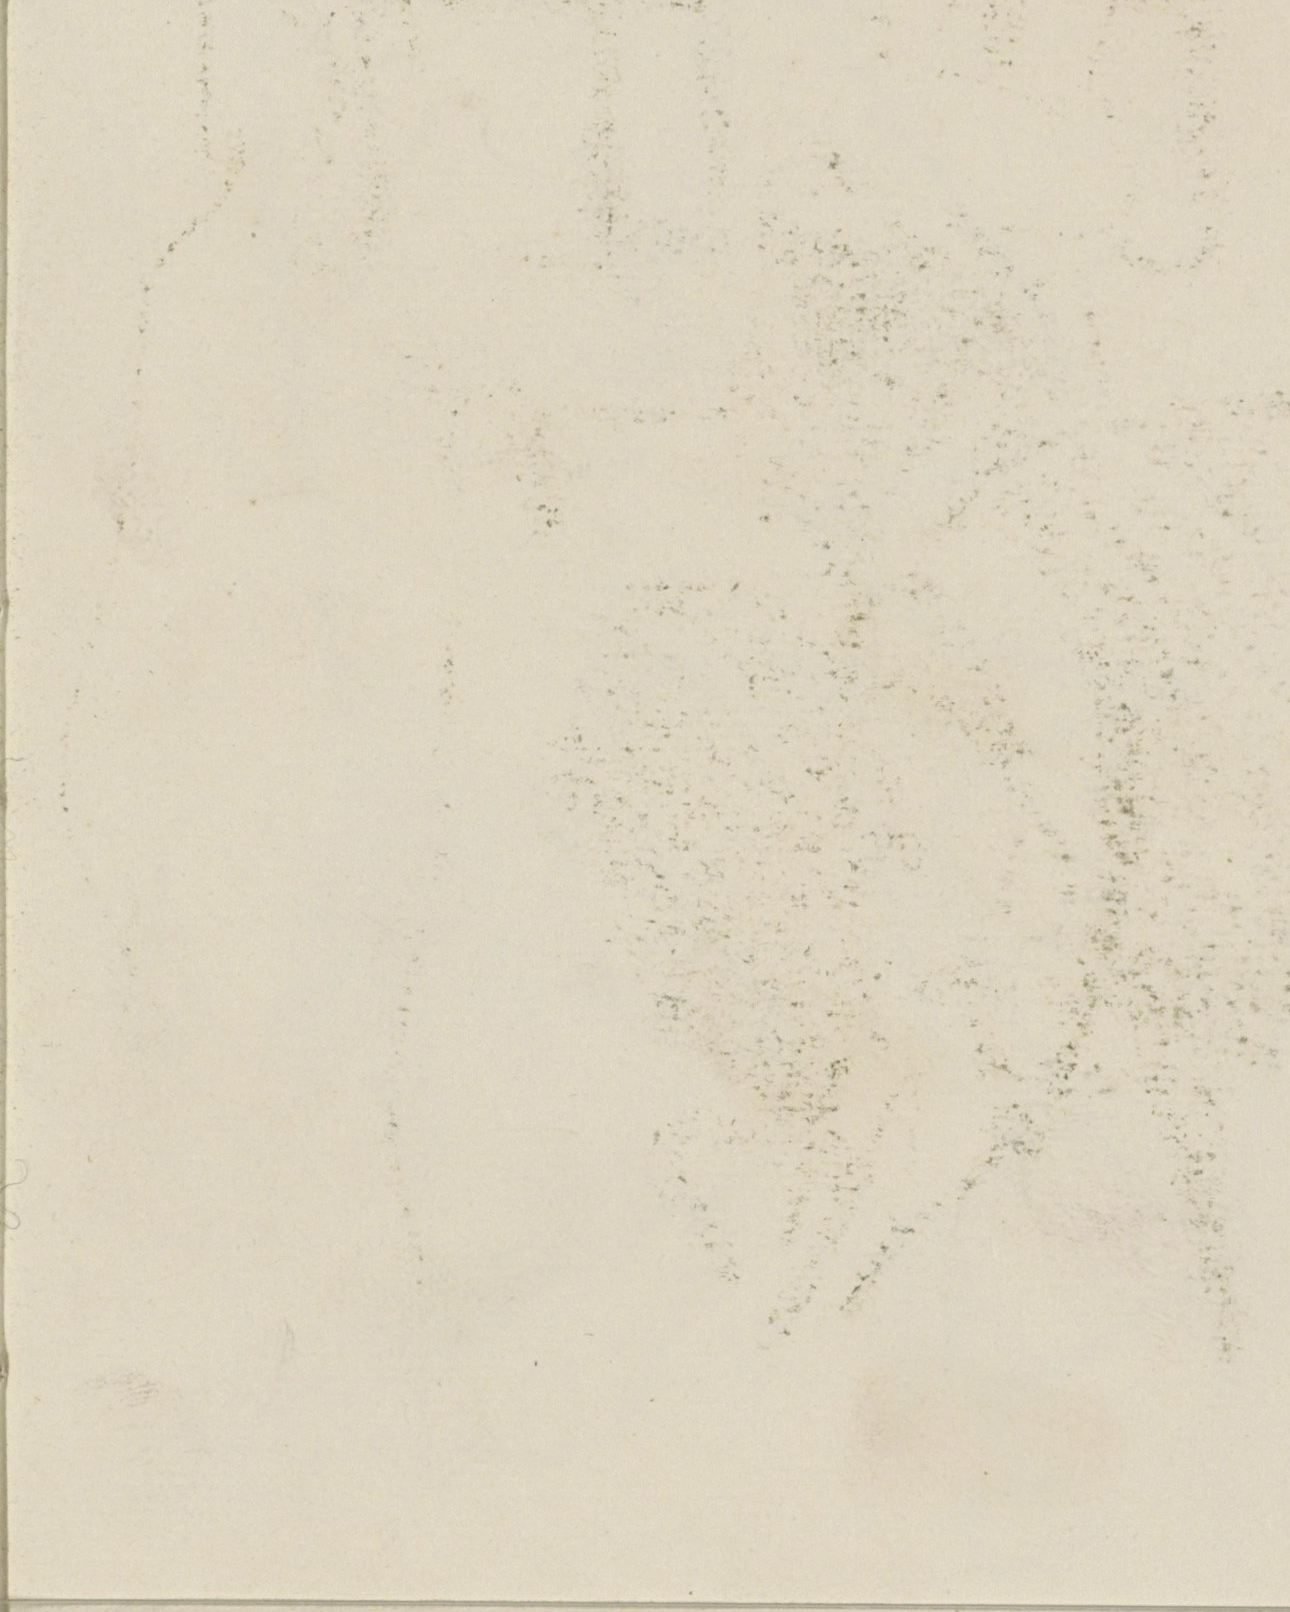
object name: sketchbook leaf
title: Abklatsch van de krijttekening op pagina 58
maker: isaac israels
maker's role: draughtsman, painter, print maker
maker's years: 1865-1934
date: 1886-1903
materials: paper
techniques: printmaking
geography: amsterdam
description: Pagina 59 uit schetsboek XXXII met 92 pagina's.